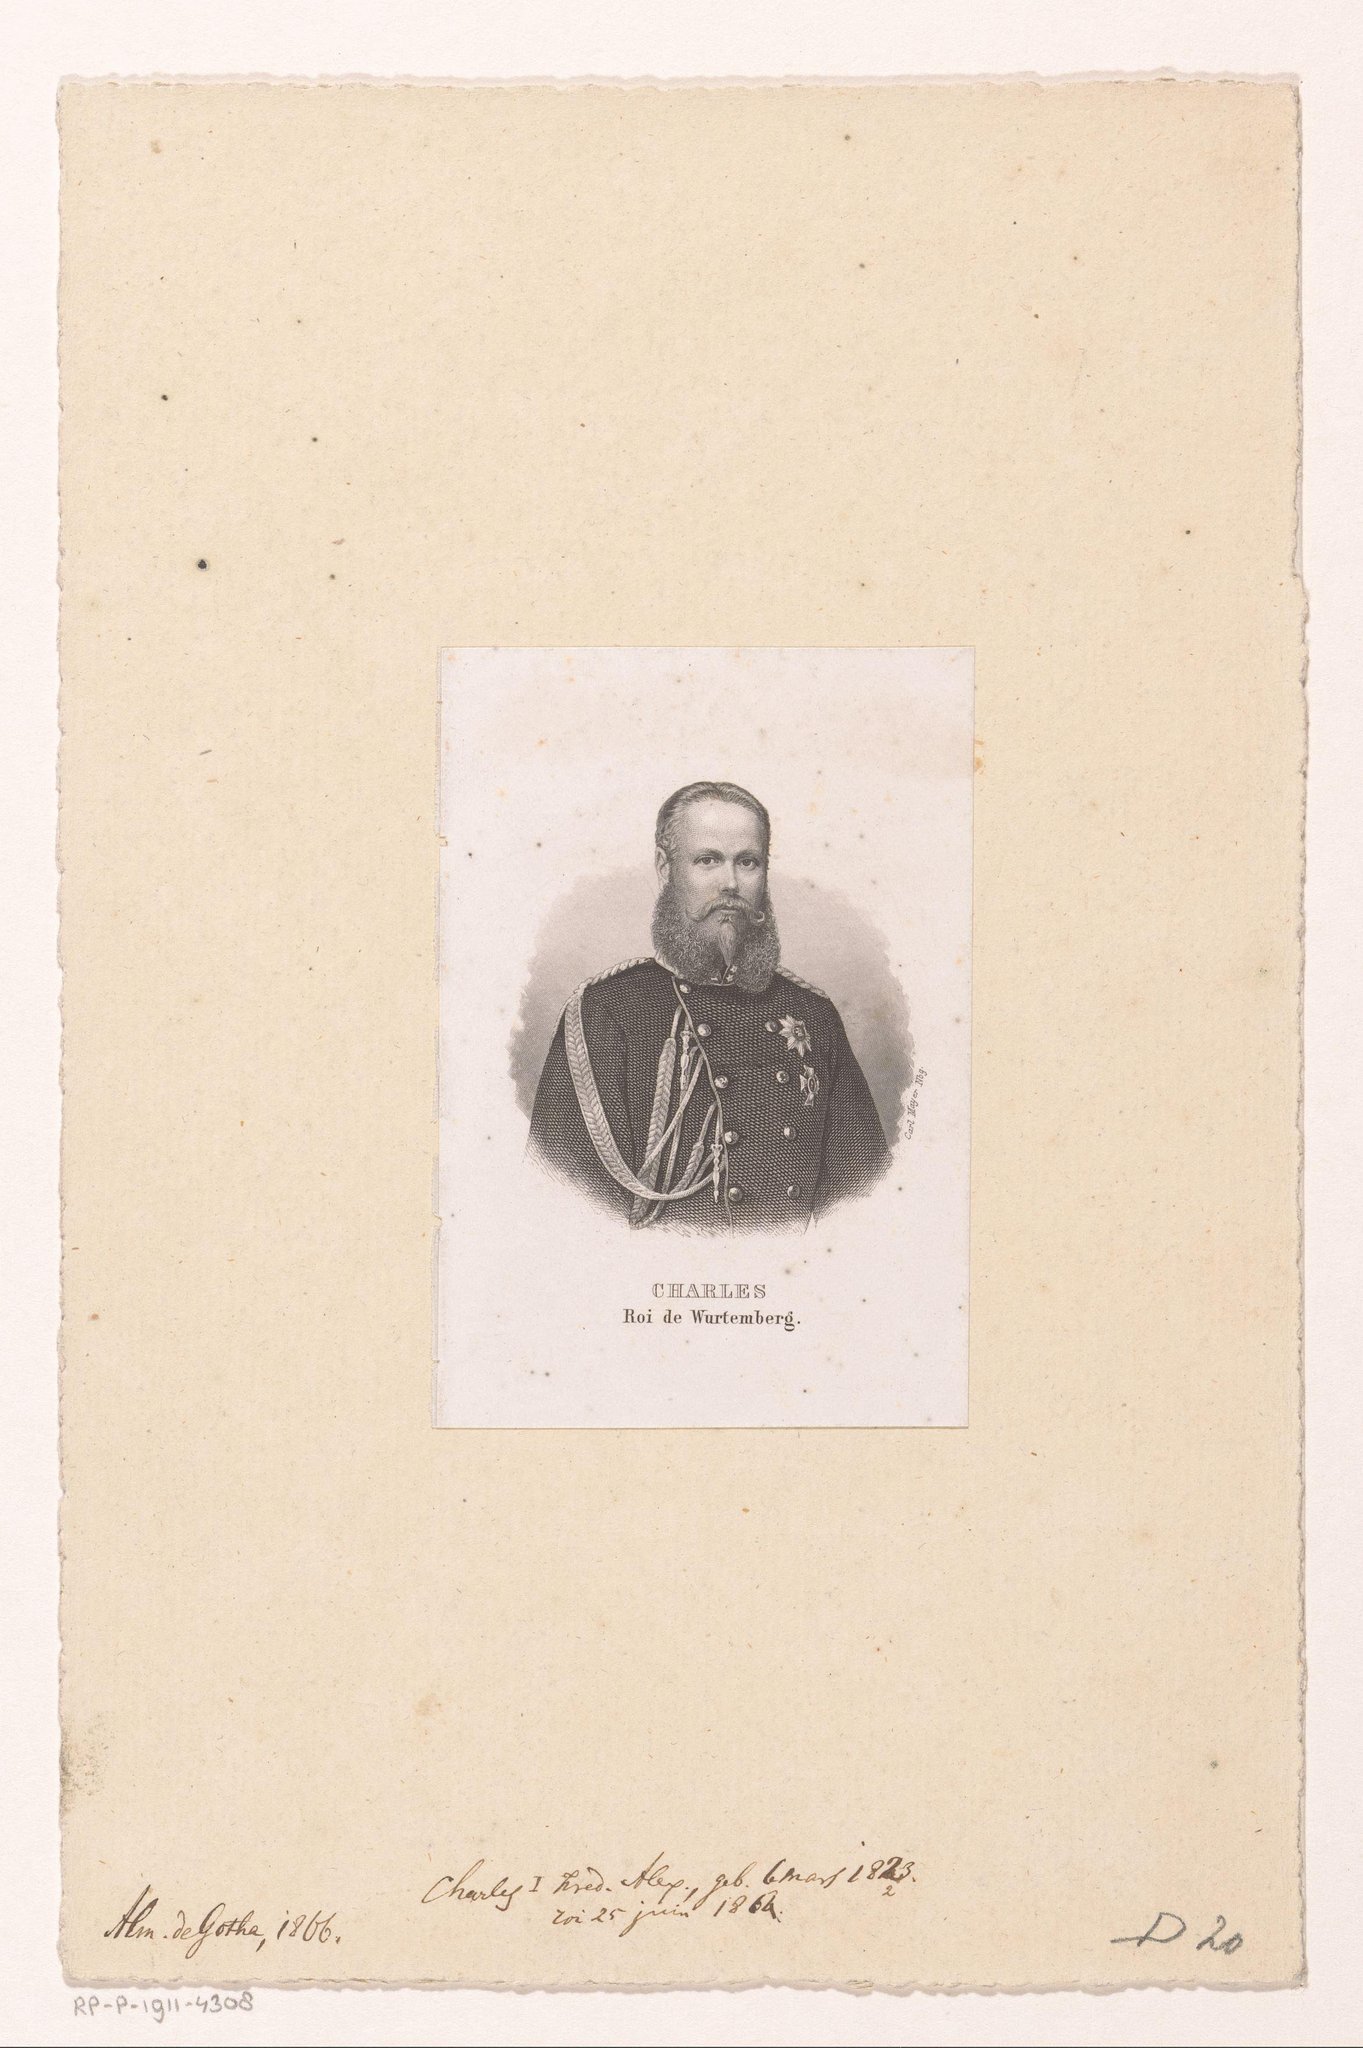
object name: book illustration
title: Portret van Karl I, koning van Wurtemberg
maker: carl mayer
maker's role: print maker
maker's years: 1798-1868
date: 1866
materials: paper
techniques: engraving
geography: nuremberg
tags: historical persons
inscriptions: collector's mark: Lugt 2228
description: Vermoedelijk afkomstig uit: Almanach de Gotha, 1866.